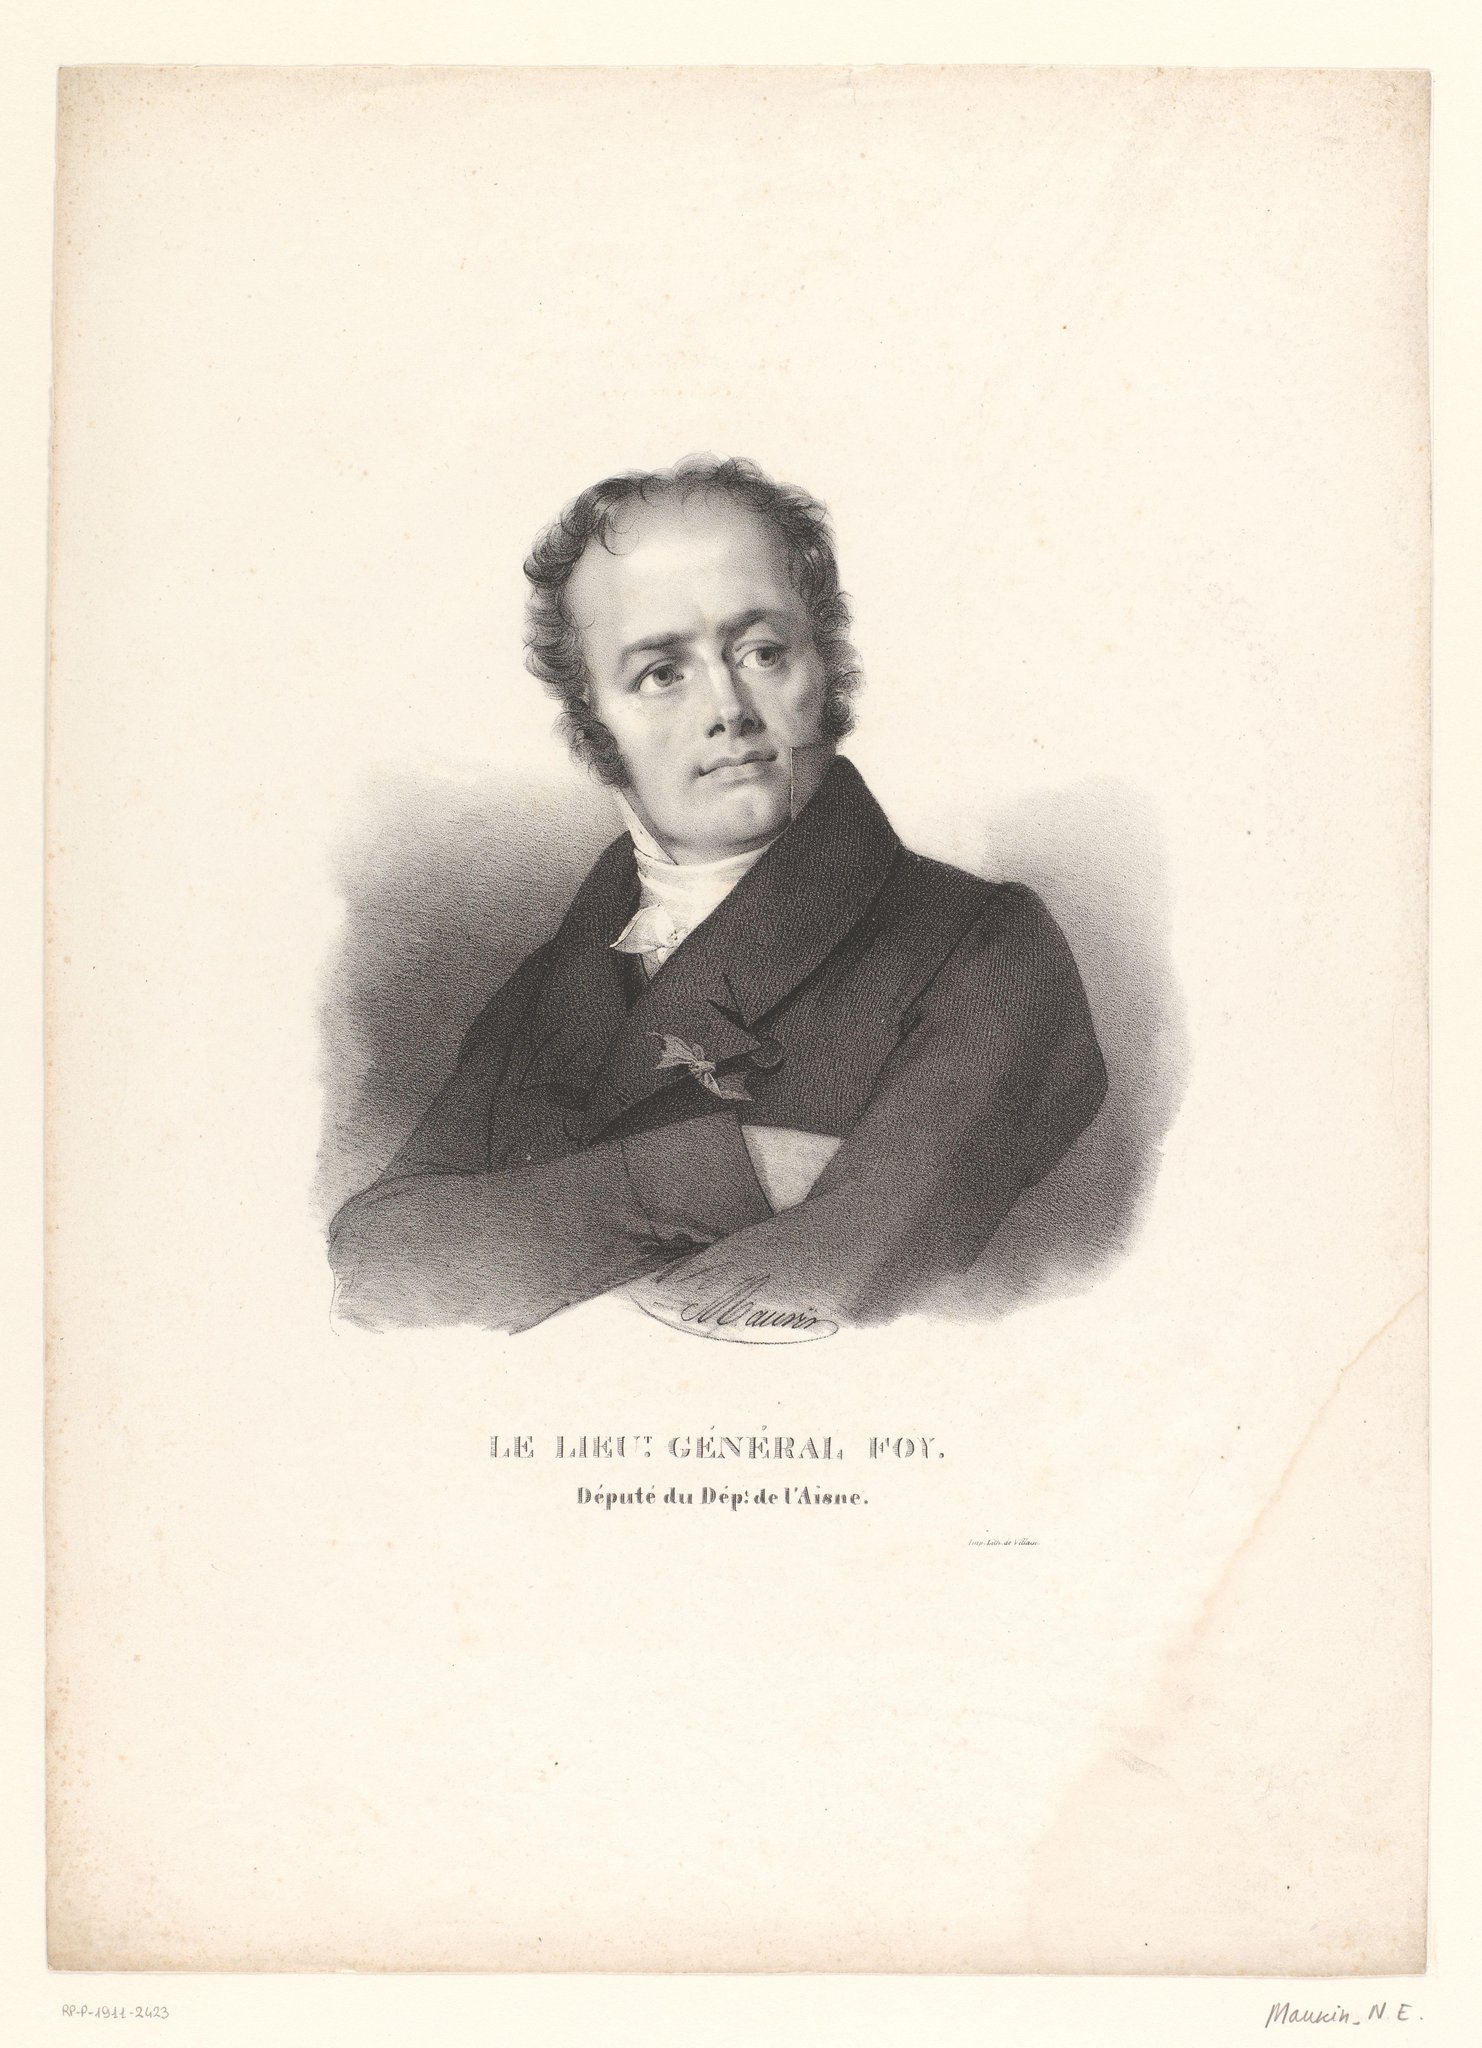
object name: print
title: Le lieut. général Foy. Député du dépt. de l'Aisne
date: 1818-1852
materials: paper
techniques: lithograph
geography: paris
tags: paris, politician, maximilien sébastien foy, historical persons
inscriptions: collector's mark: Lugt 2228